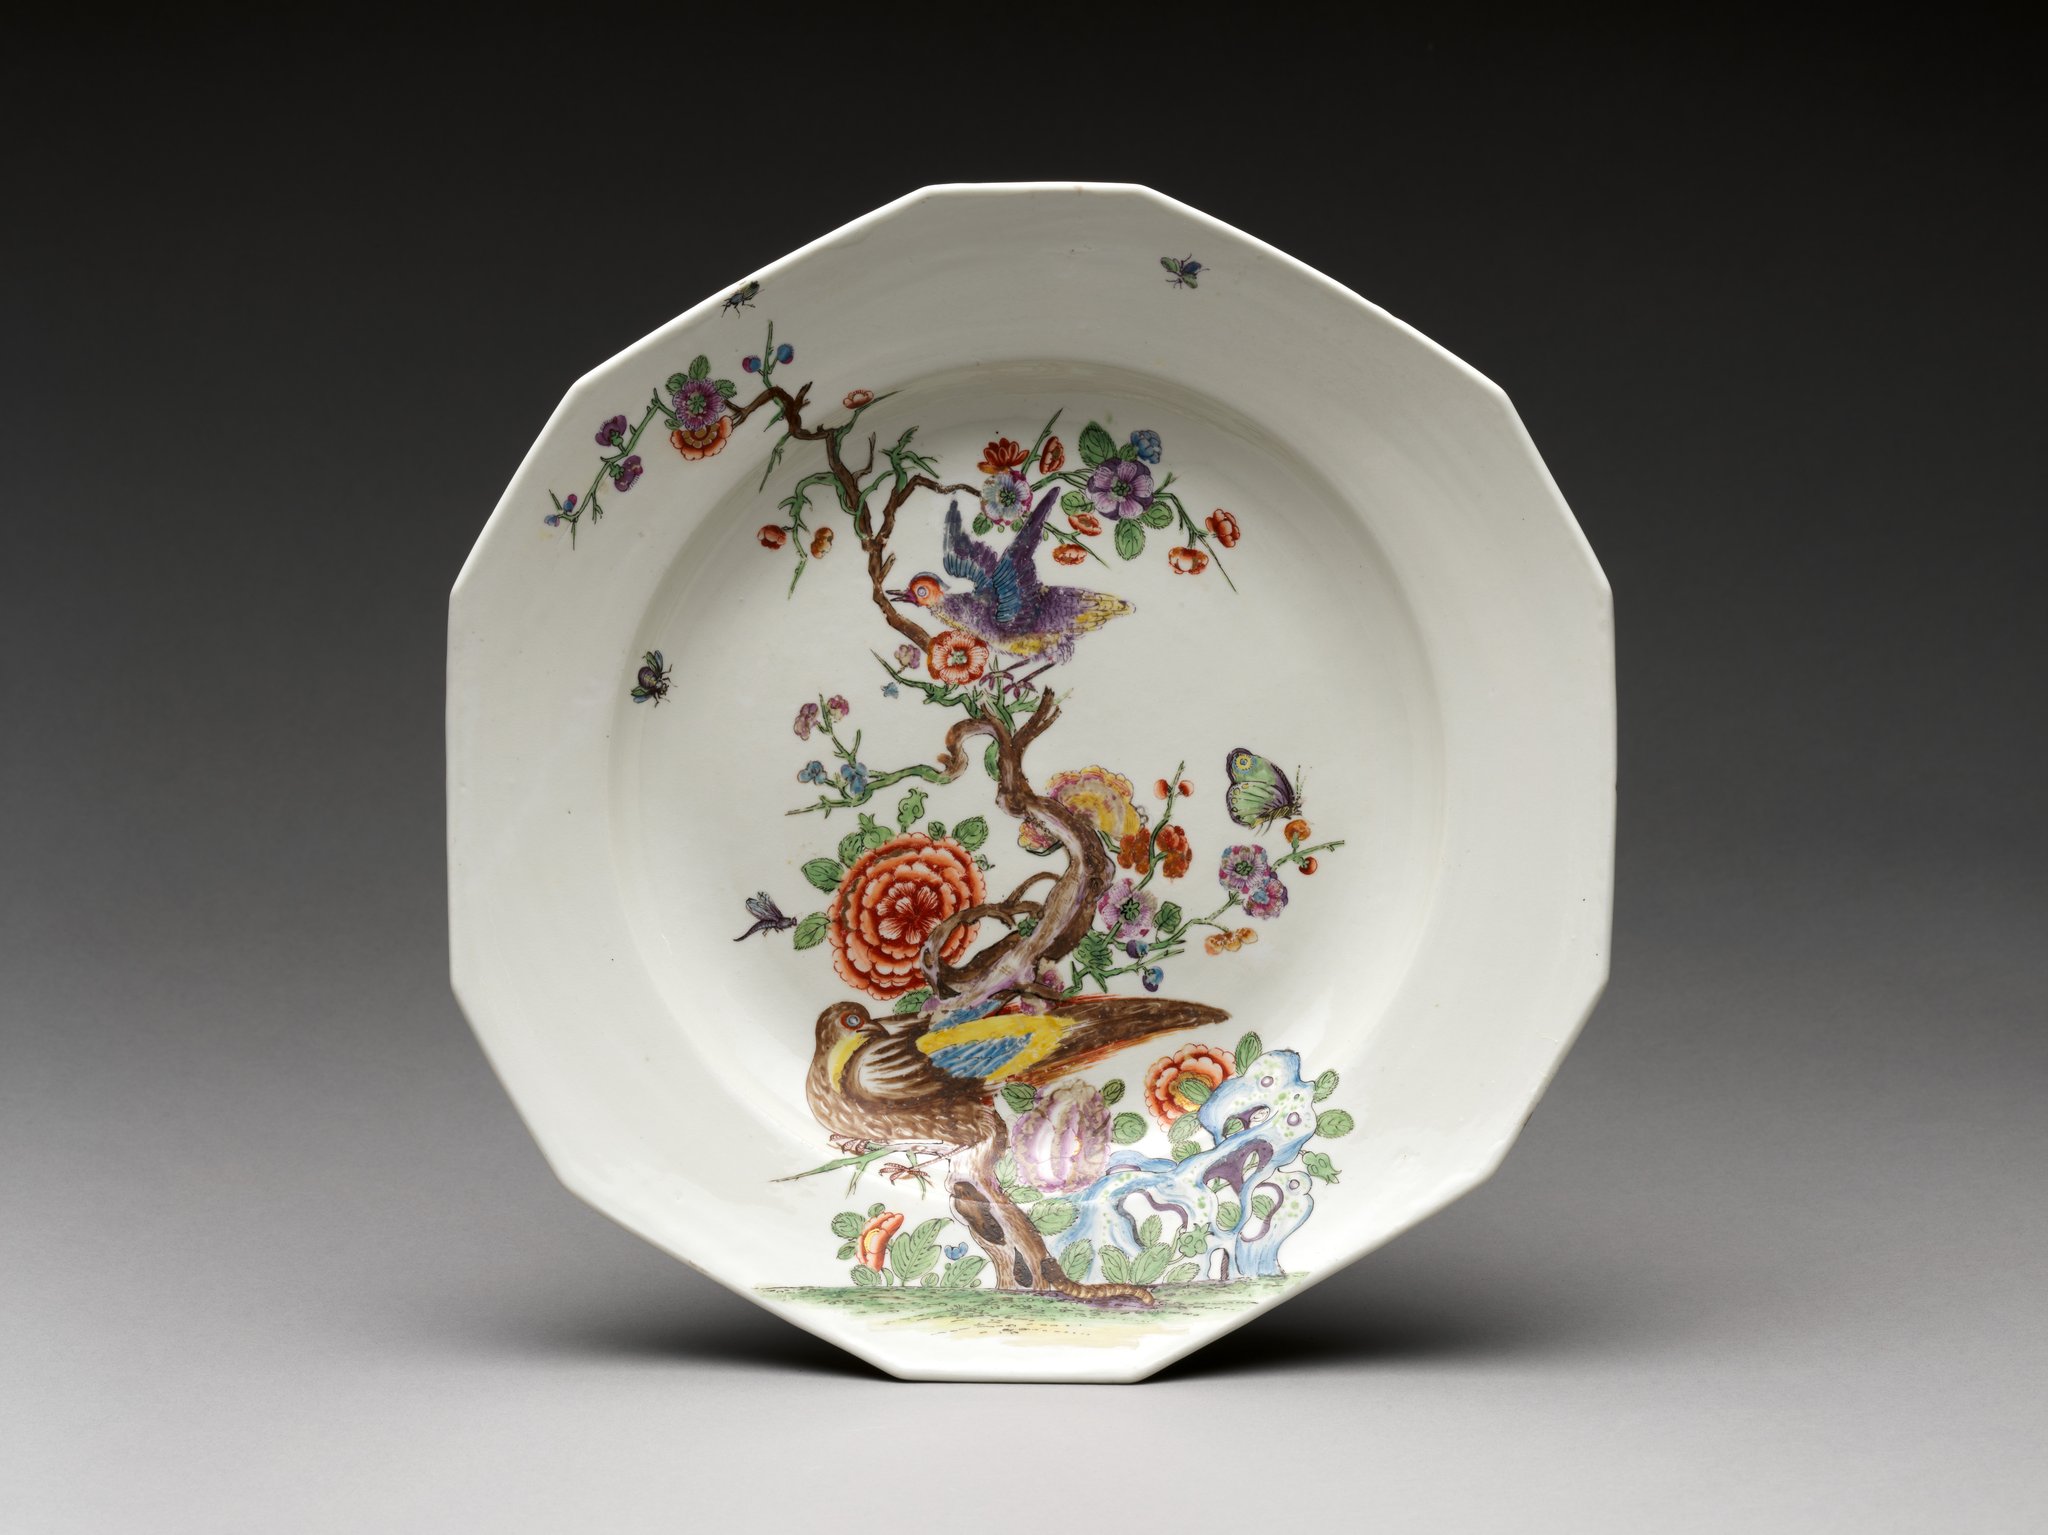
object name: dish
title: Dish with tree, flowers, and birds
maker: vienna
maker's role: manufactory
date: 1722-1723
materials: enamel, glaze, hard paste porcelain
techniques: painting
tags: birds,insects,butterflies,flowers